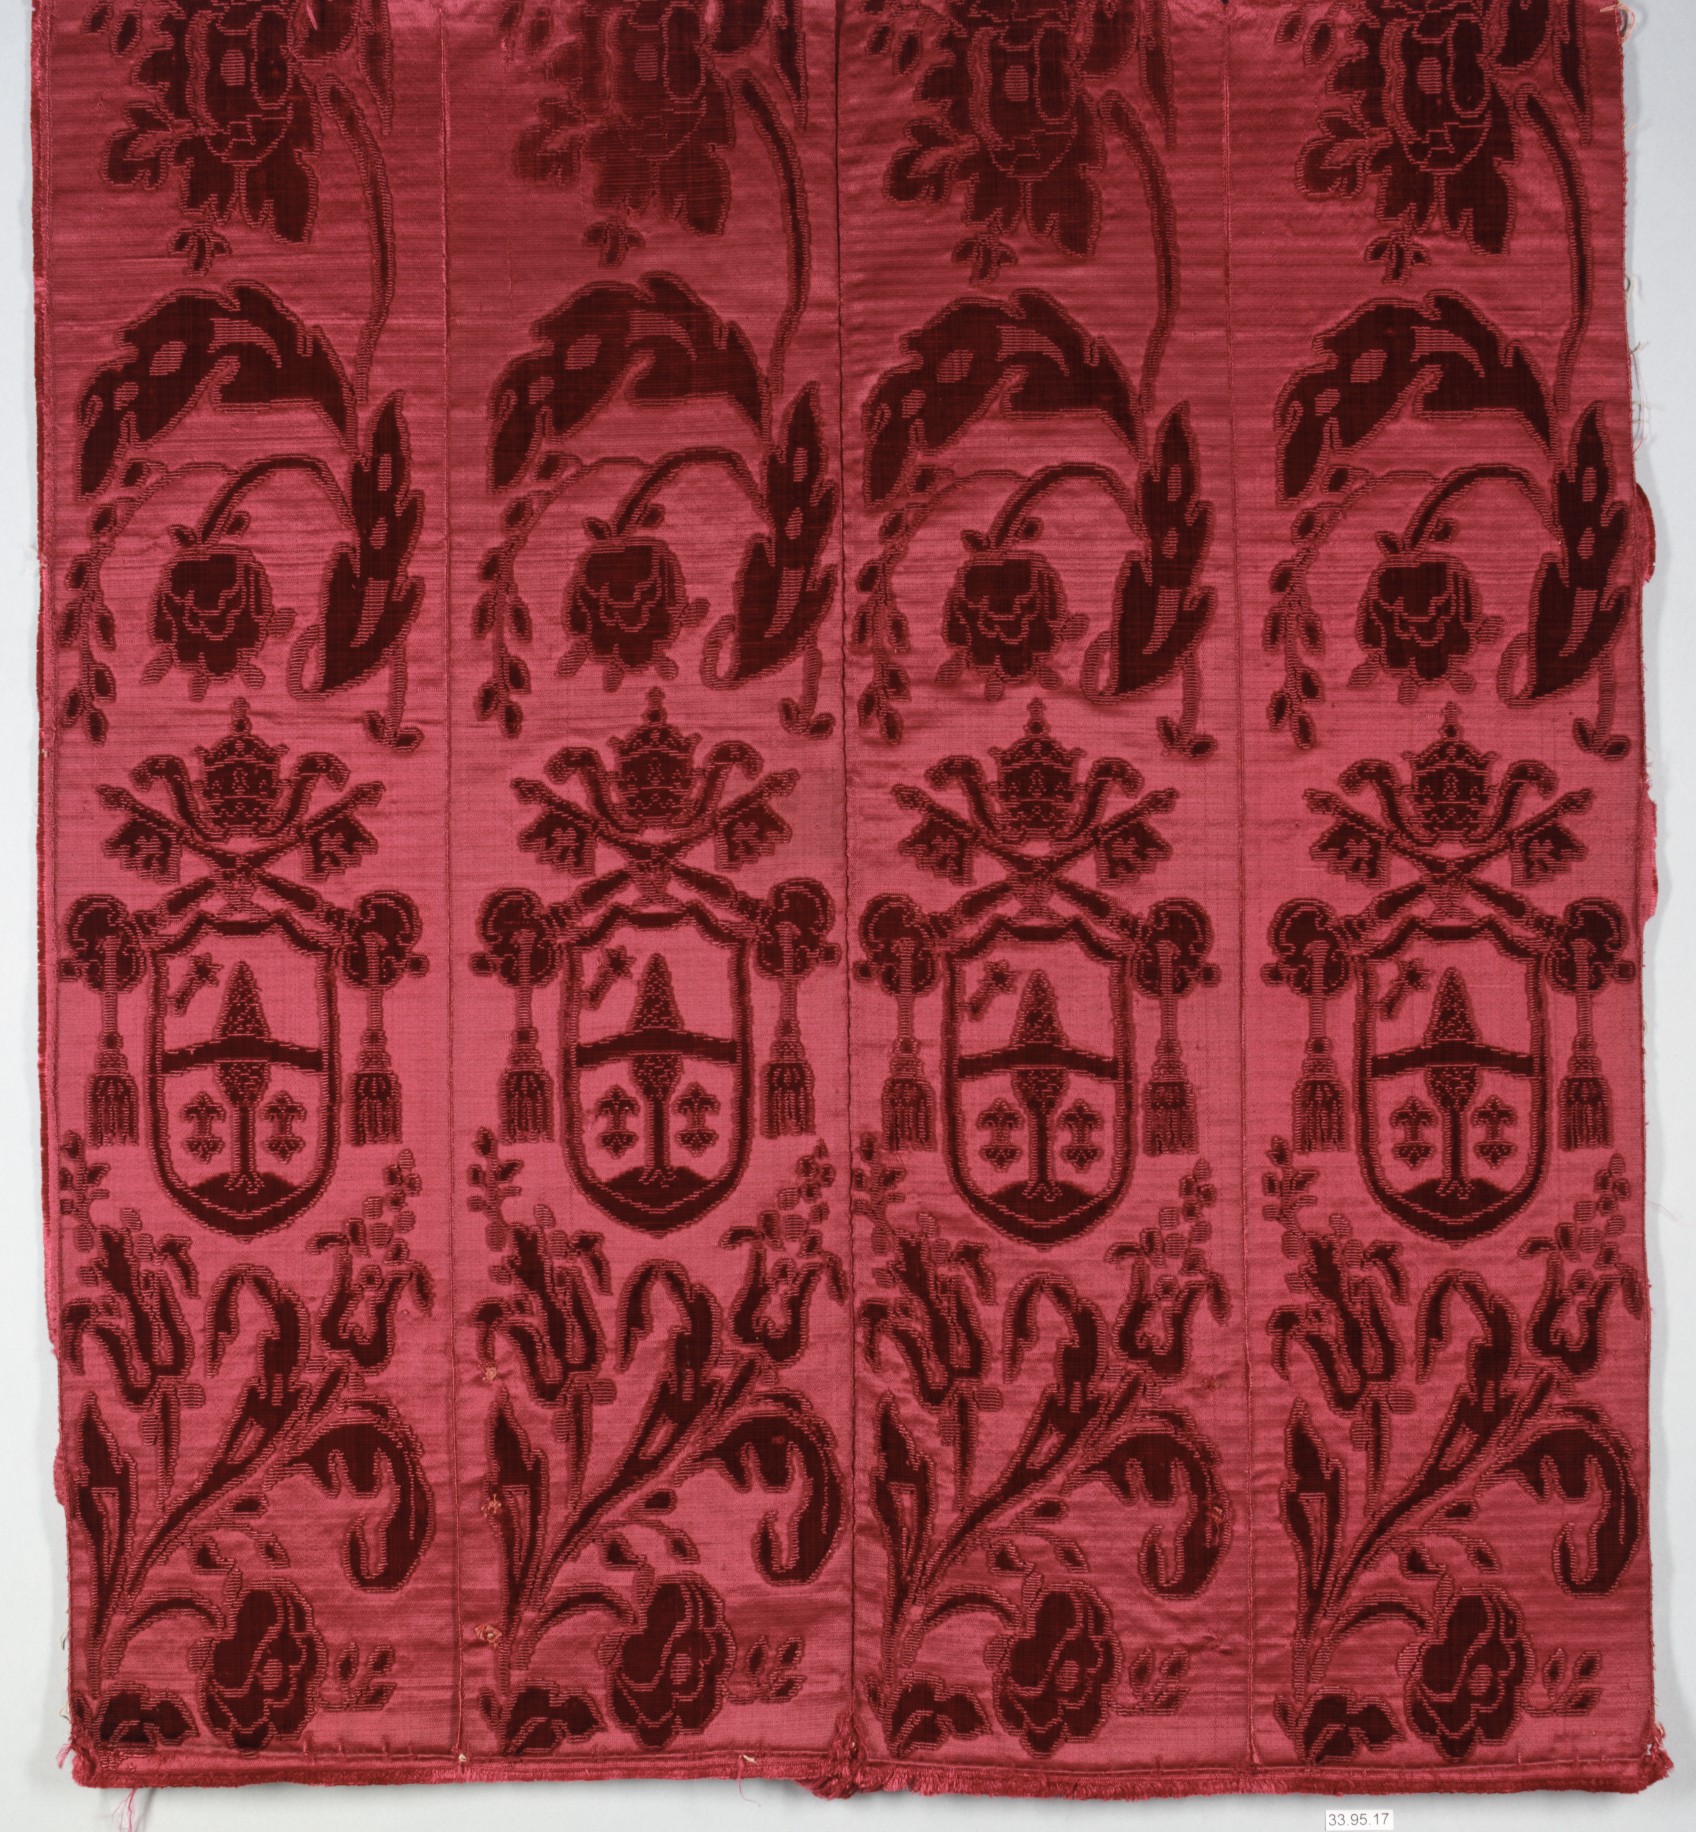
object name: piece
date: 1867-1900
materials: silk